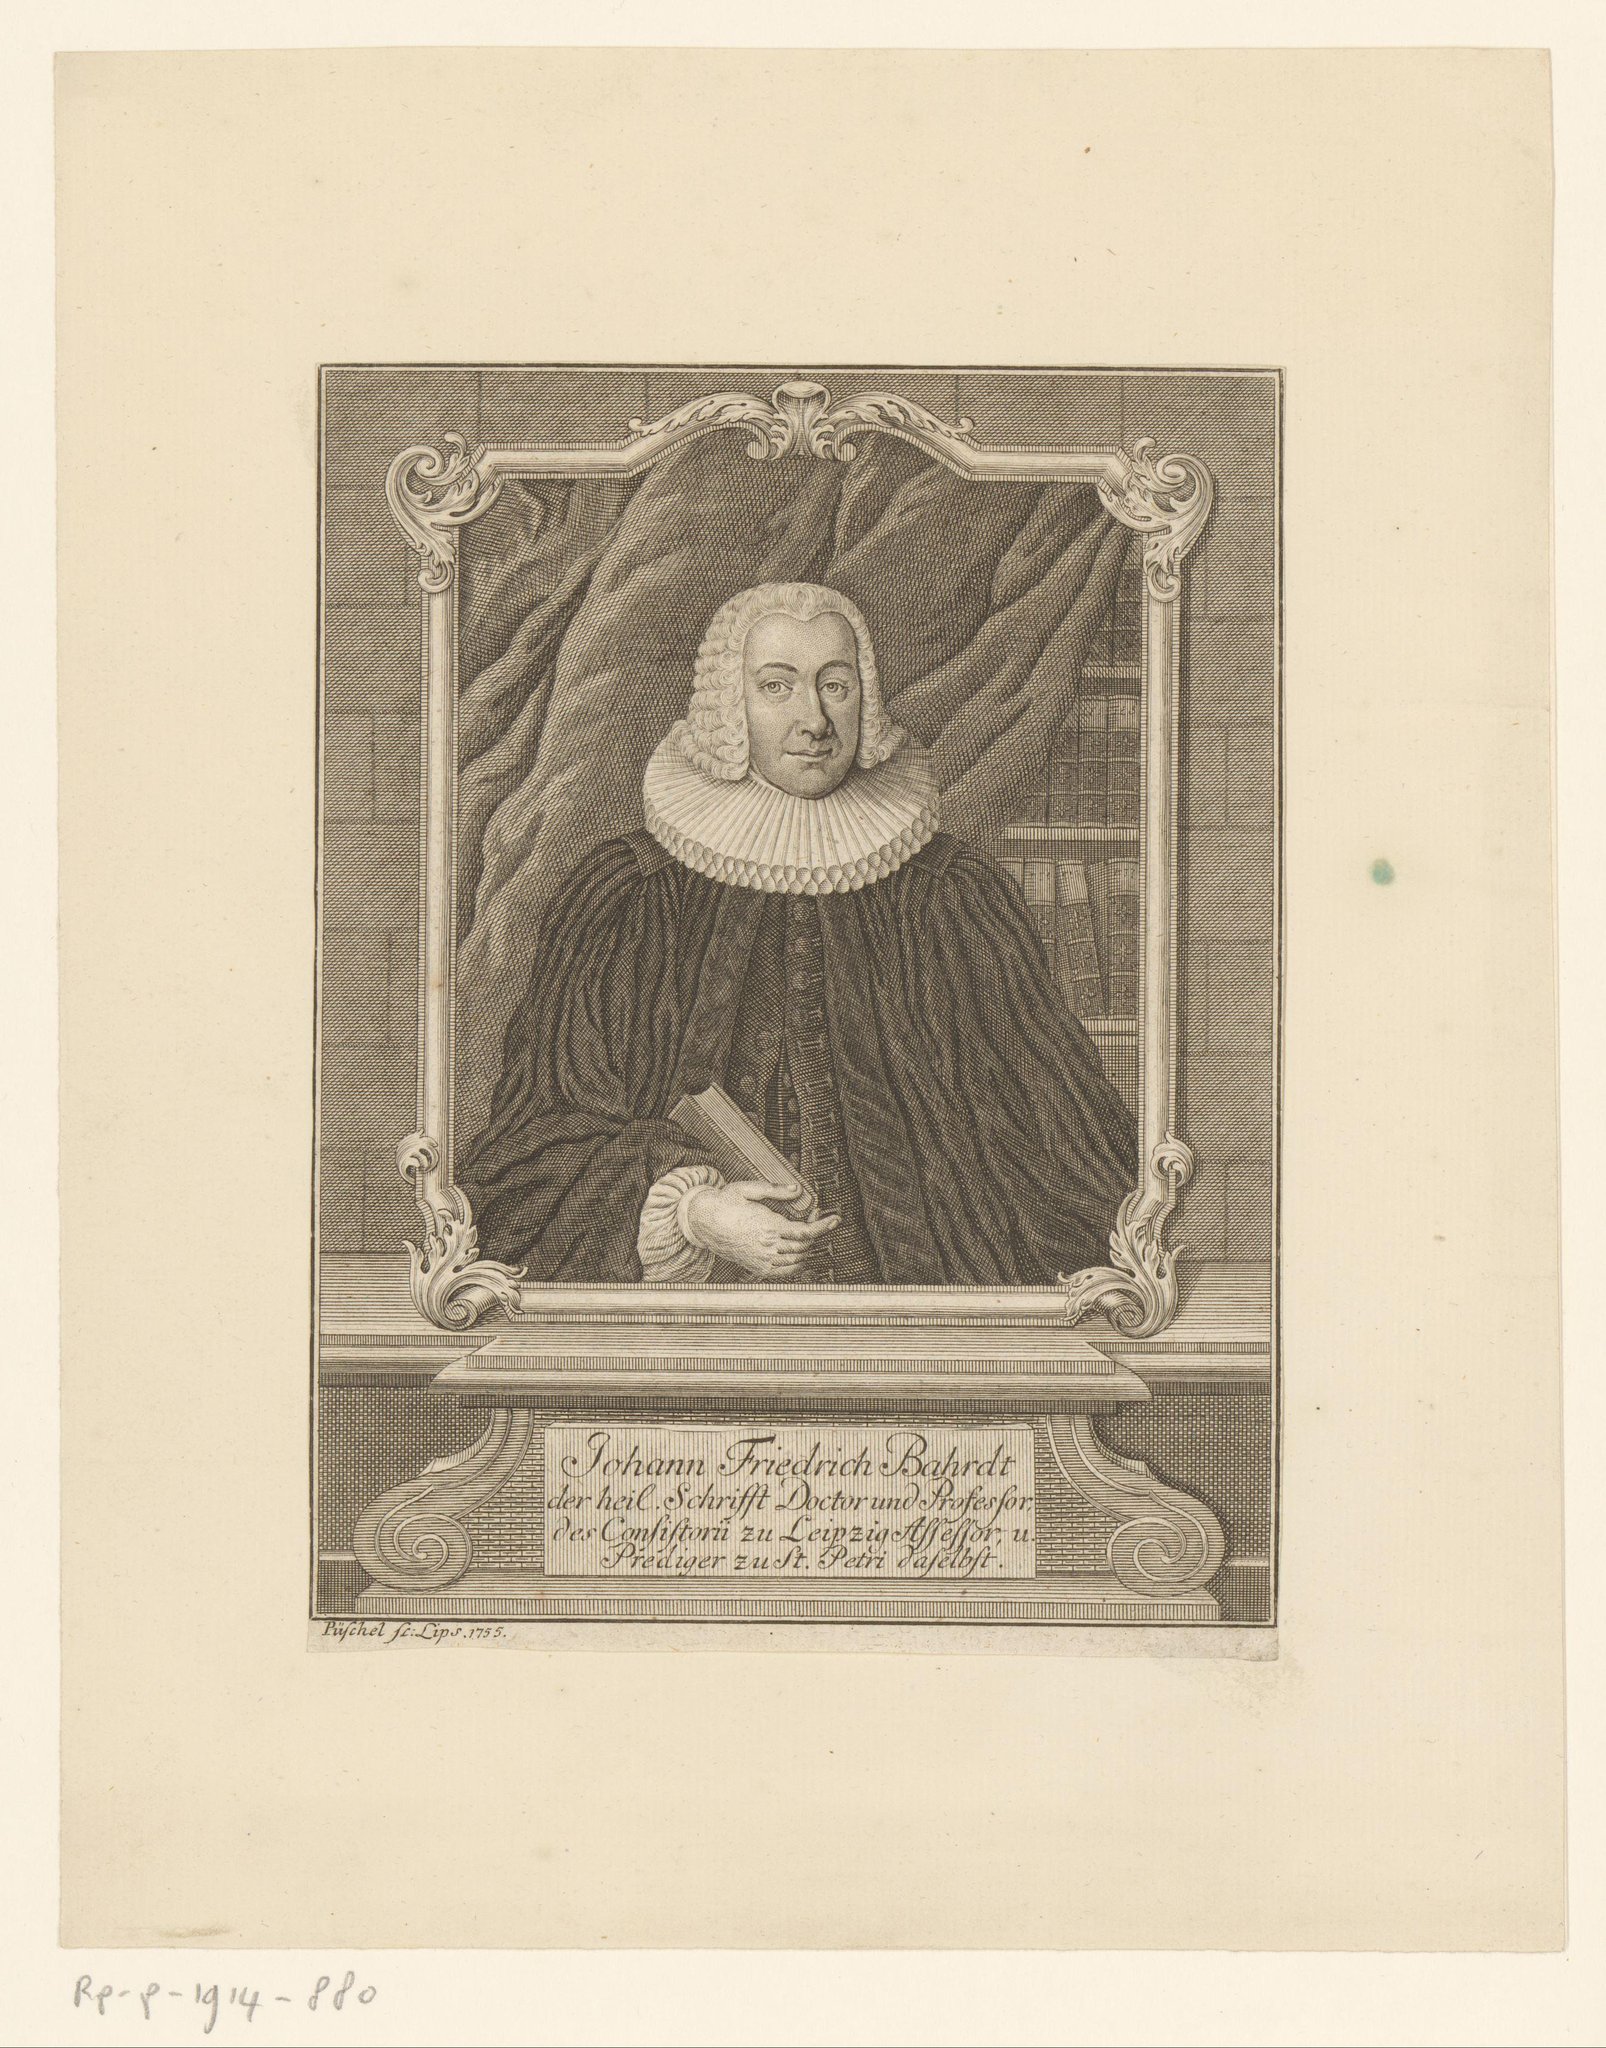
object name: print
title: Portret van Johann Friedrich Bahrdt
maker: johann christian püschel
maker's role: print maker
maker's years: 1718-1771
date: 1728-1771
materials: paper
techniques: engraving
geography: leipzig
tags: bookshelves, historical persons, book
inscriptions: collector's mark: Lugt 2228